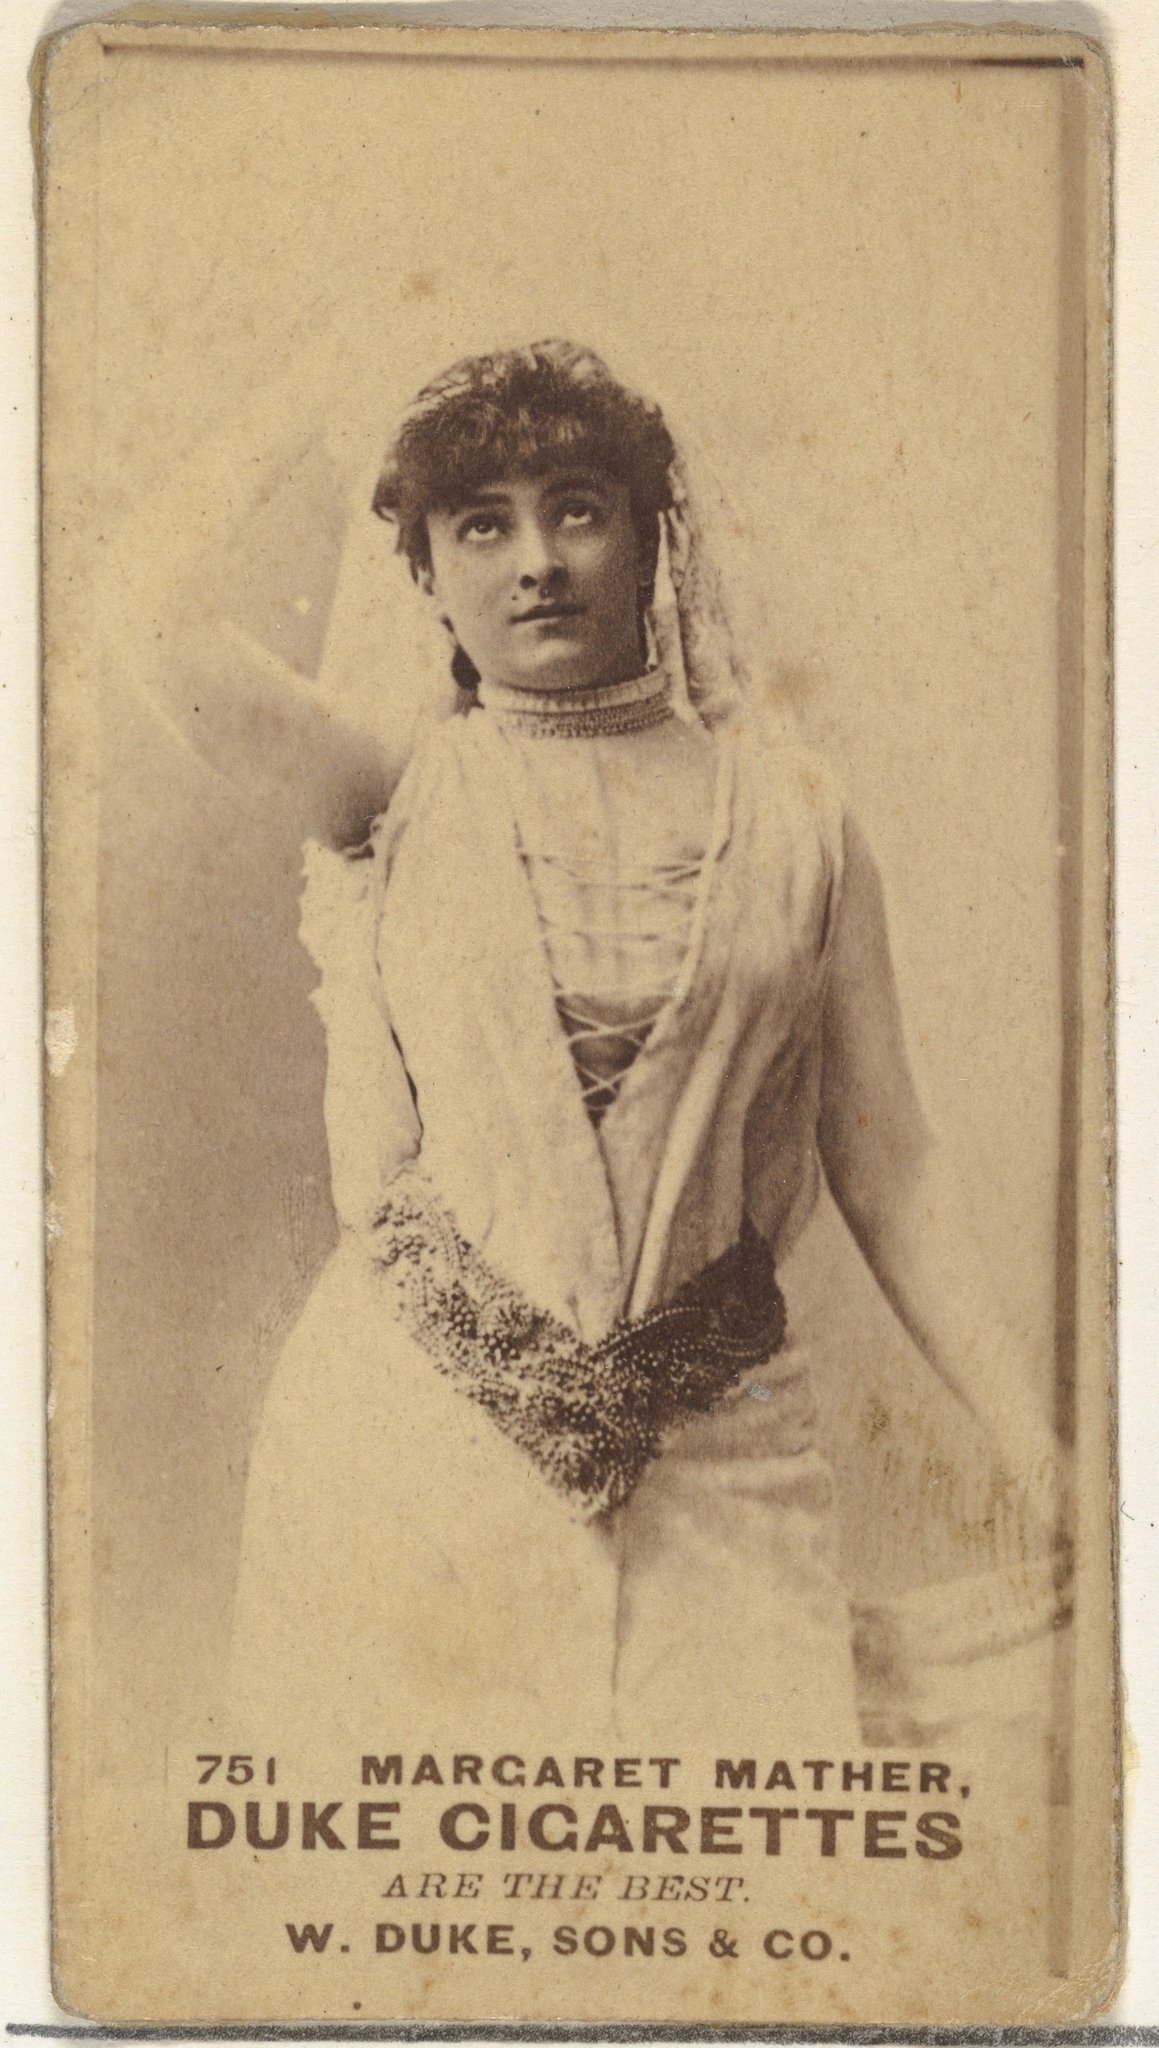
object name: photograph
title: Card Number 751, Margaret Mather, from the Actors and Actresses series (N145-7) issued by Duke Sons & Co. to promote Duke Cigarettes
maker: w. duke, sons & co.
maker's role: publisher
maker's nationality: american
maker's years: 1870-1920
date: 1880-1889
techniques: albumen silver print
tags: portraits,women,actresses